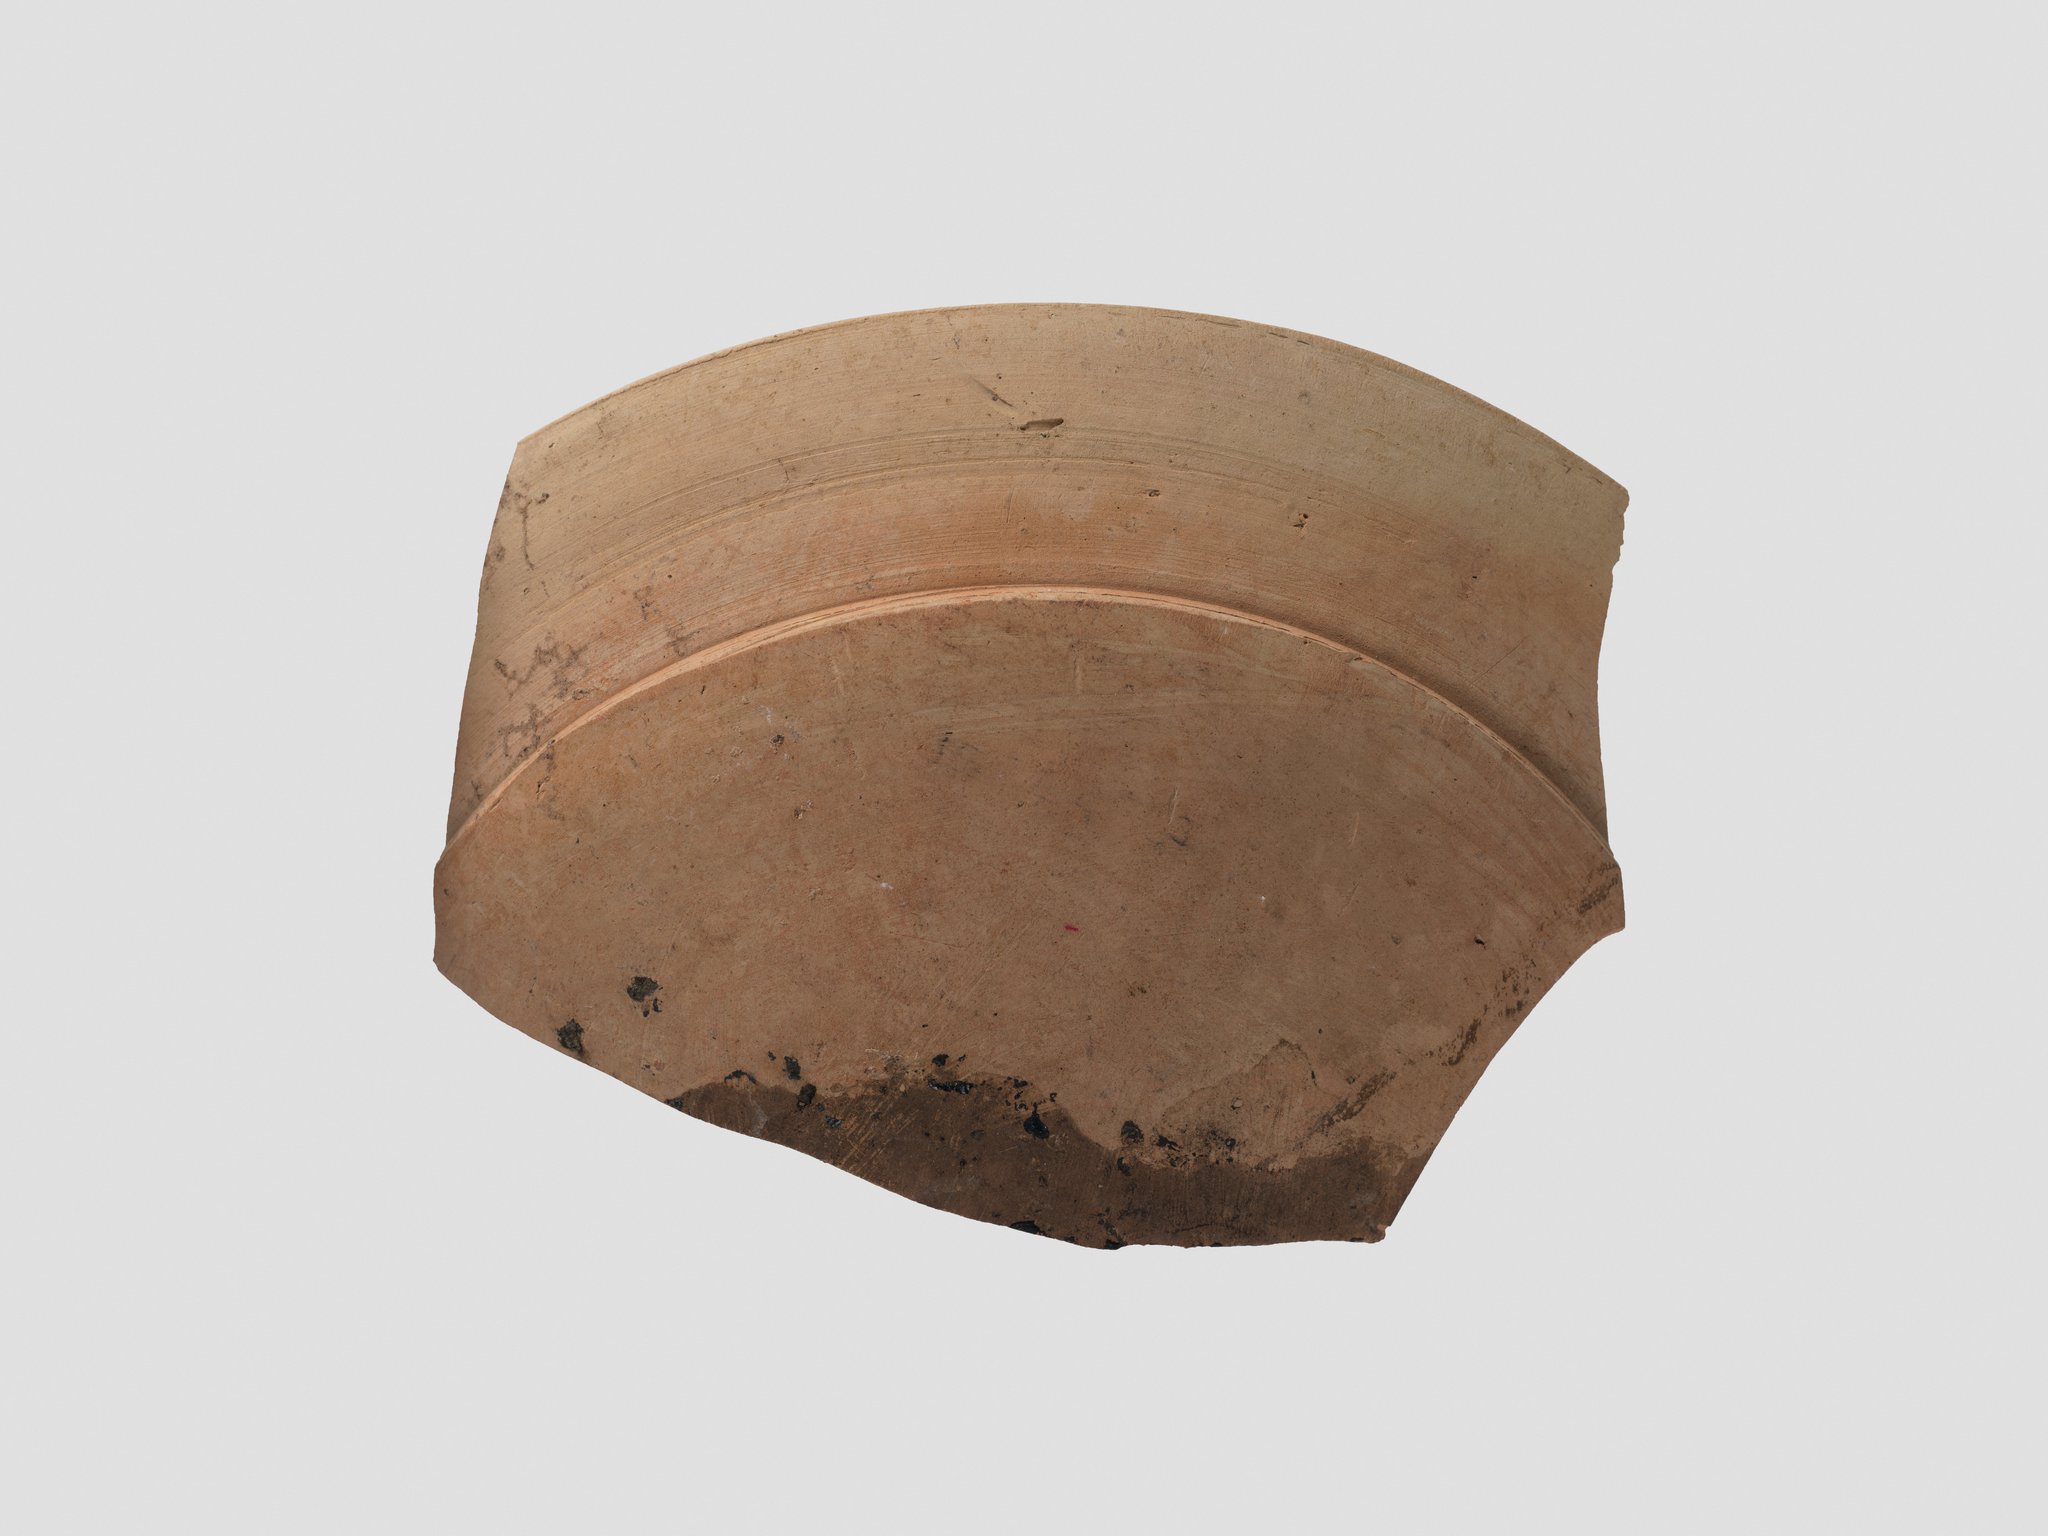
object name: bowl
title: Bowl sherd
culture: babylonian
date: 600-501 BCE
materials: ceramic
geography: mesopotamia